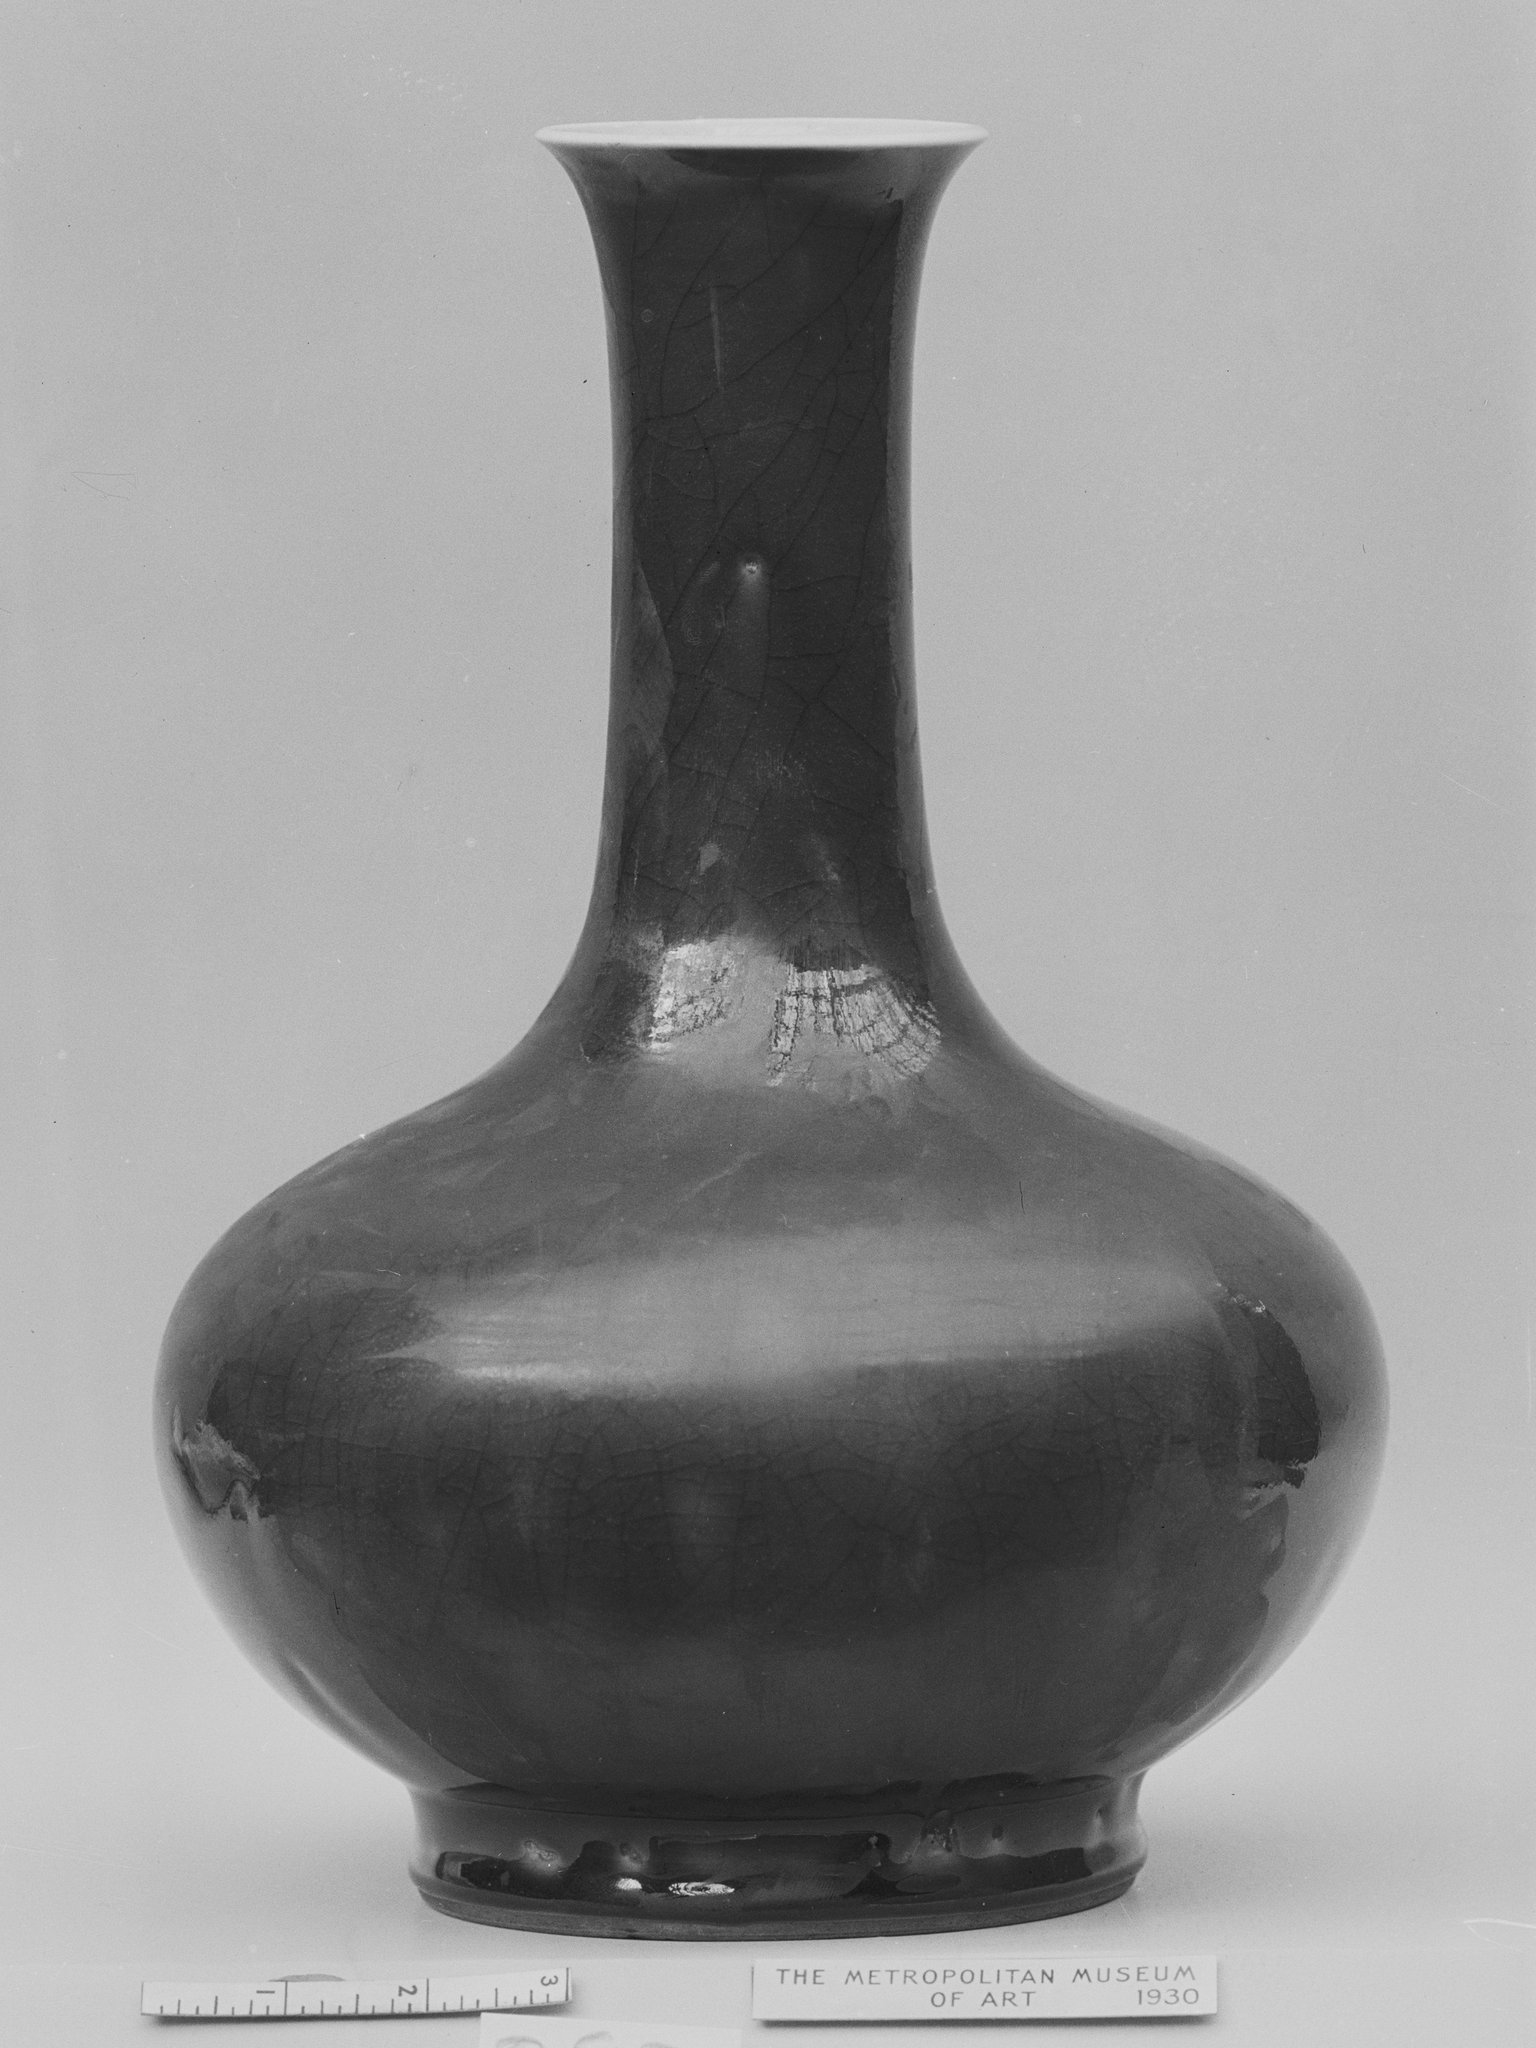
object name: vase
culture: chinese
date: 1723-1735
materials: glaze, porcelain